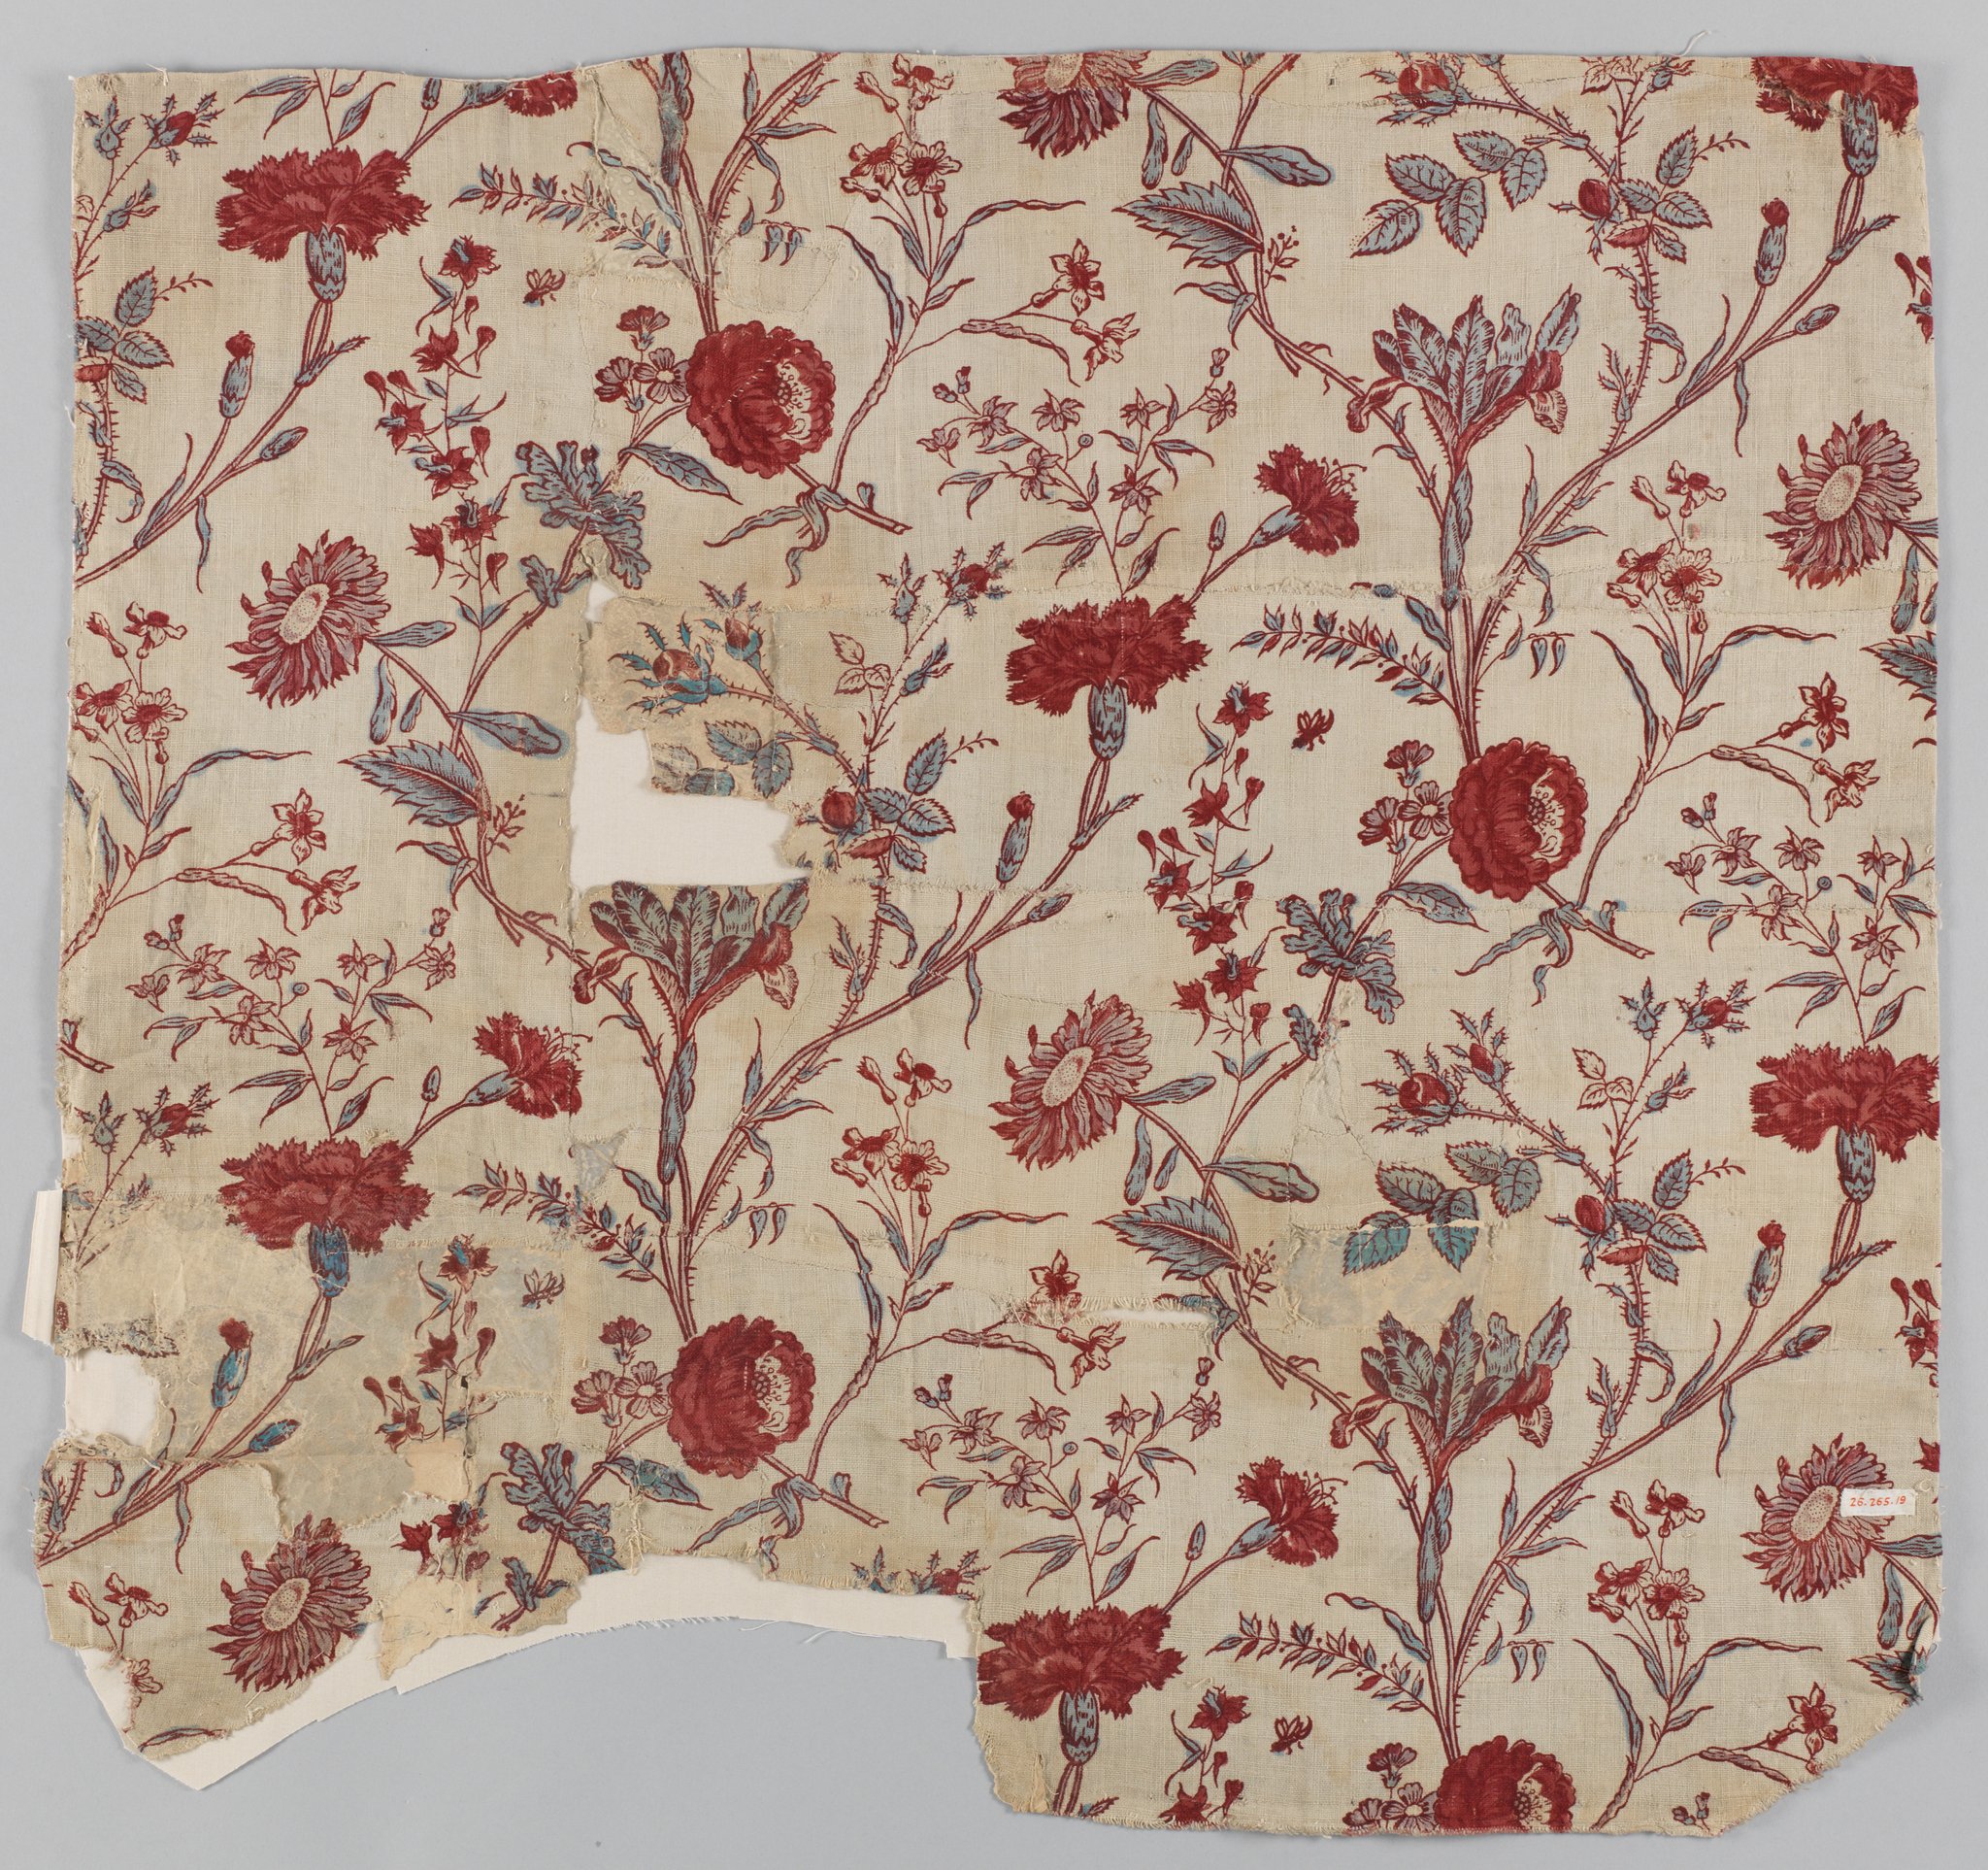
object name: piece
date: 1701-1800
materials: cotton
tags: flowers